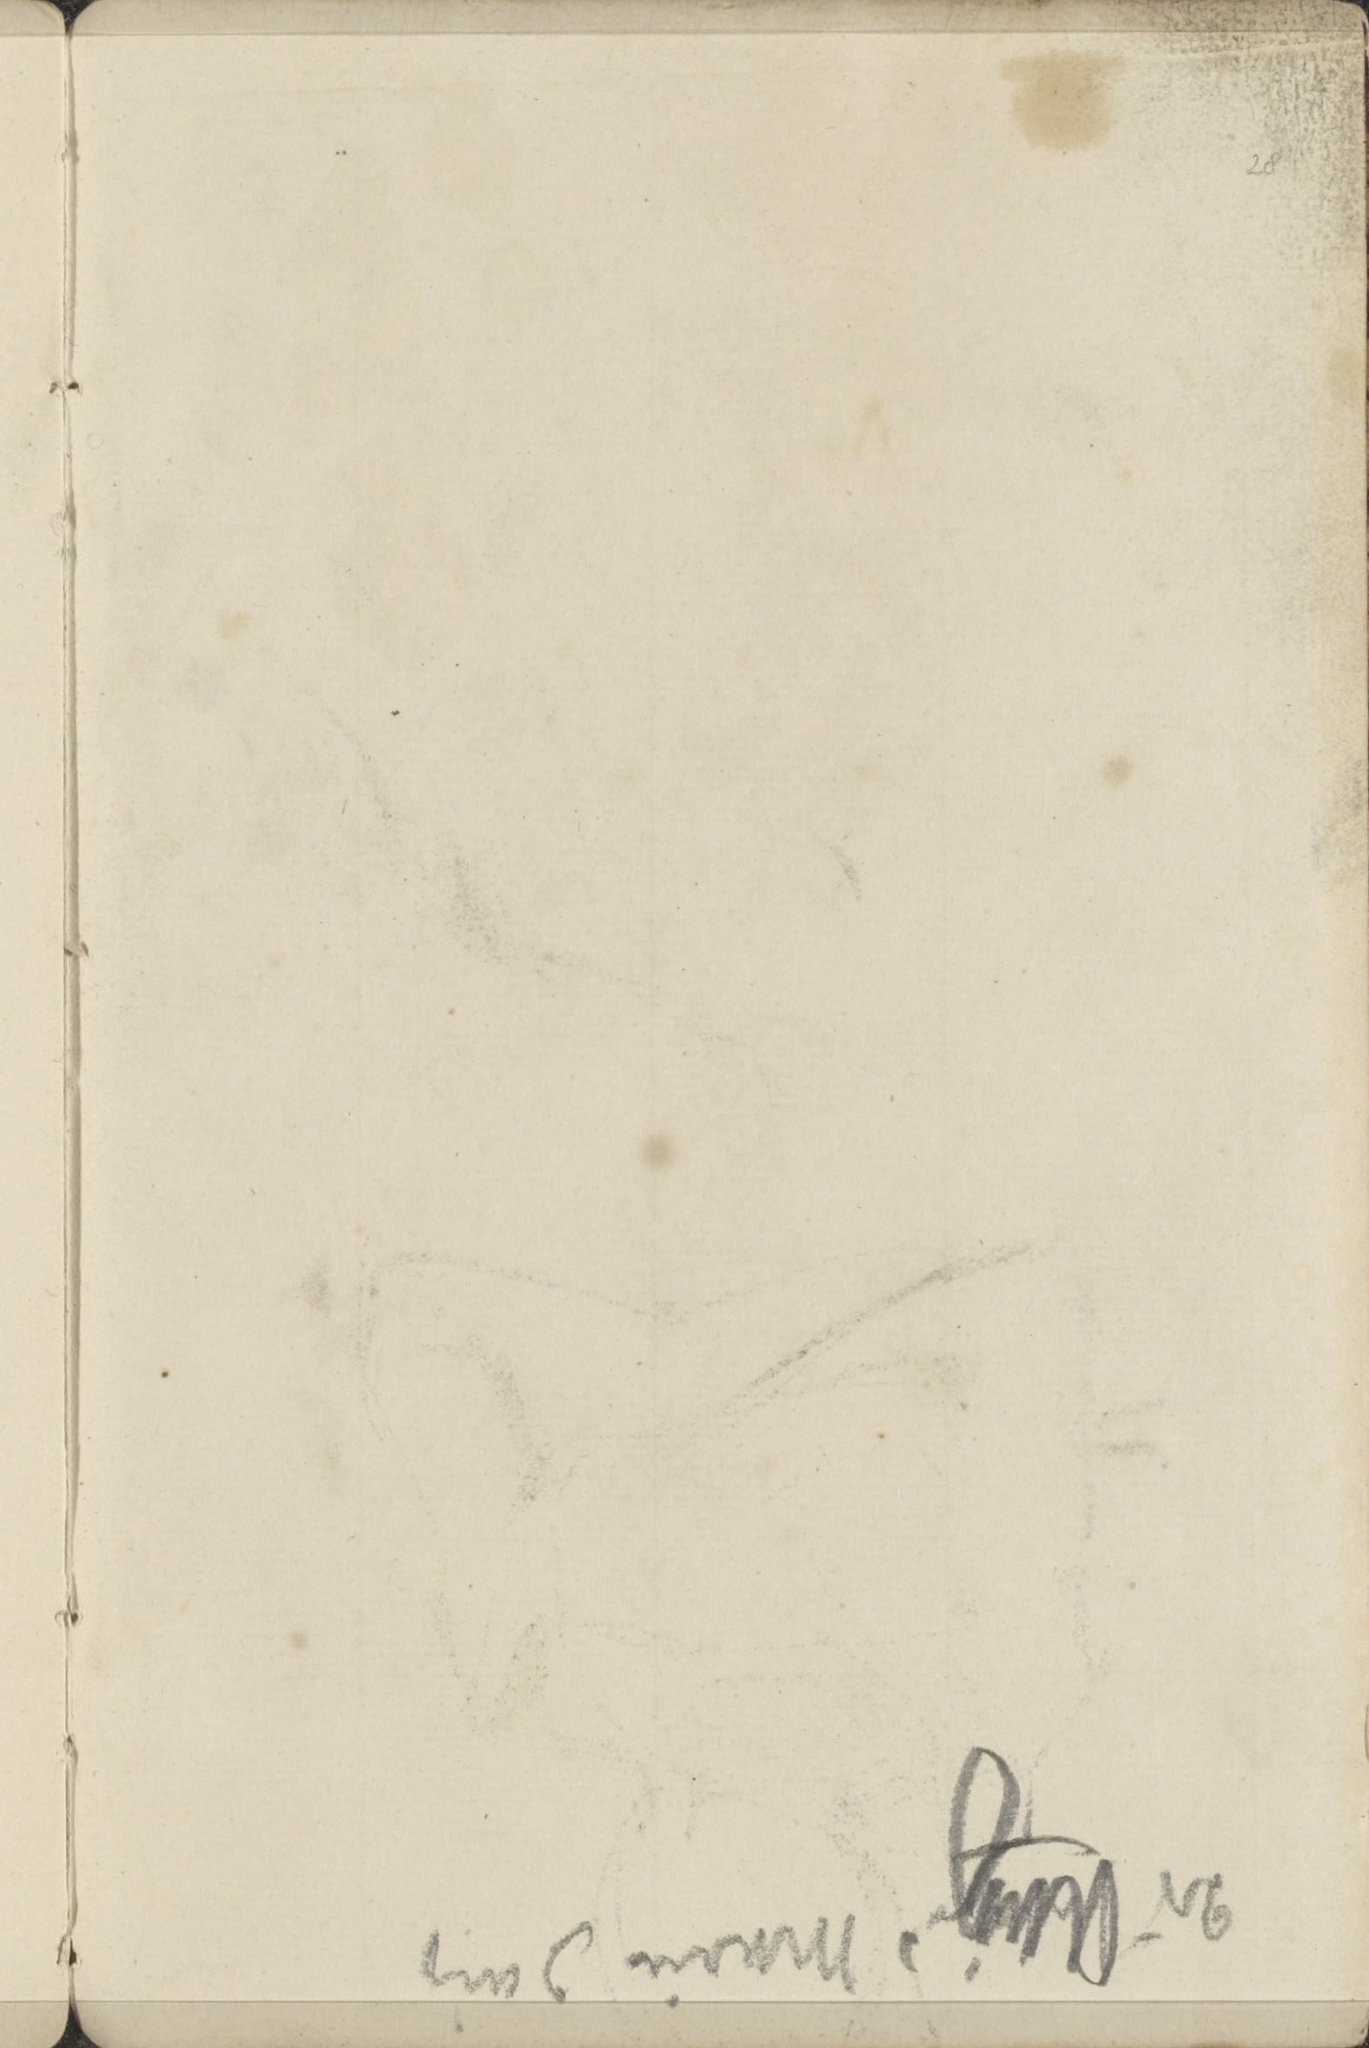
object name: sketchbook leaf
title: Annotatie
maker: george hendrik breitner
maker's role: draughtsman, painter, print maker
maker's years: 1857-1923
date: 1886-1923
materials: paper, pencil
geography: amsterdam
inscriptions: annotation: ‘25 Aug Marie jarig’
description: Pagina 28 uit een schetsboek met 14 bladen.